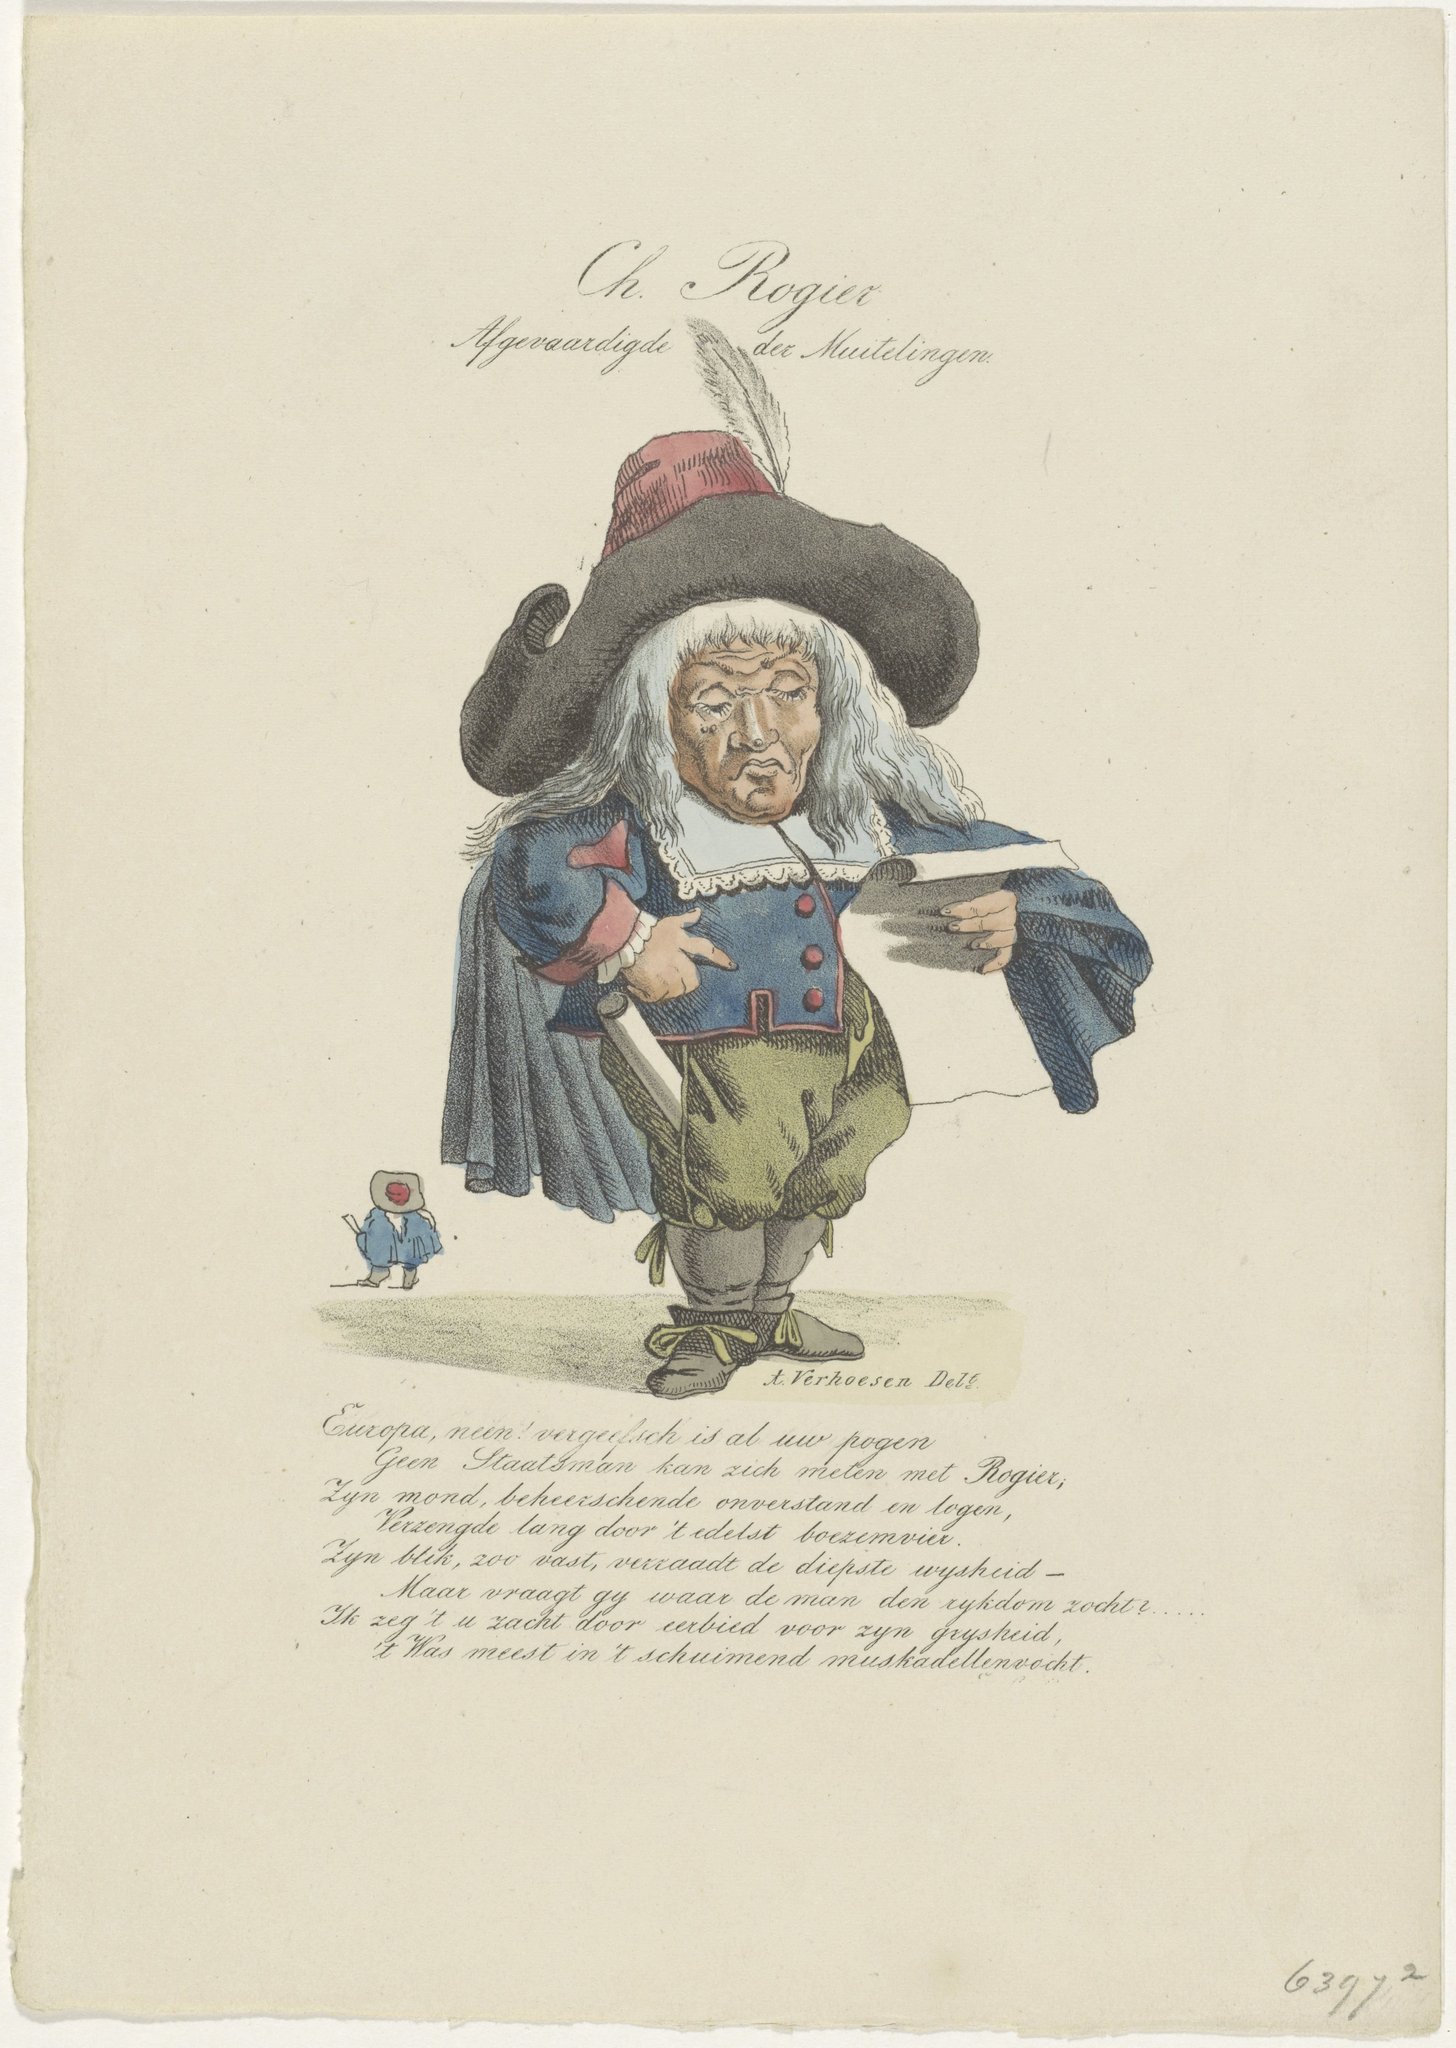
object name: print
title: Spotprent op Charles Rogier, ca. 1830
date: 1830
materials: paper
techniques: hand coloring, lithograph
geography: netherlands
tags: politician, revolutionary government, little people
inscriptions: collector's mark: Lugt 2228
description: Spotprent op de verschillende leden van het Voorlopig Bewind van België in 1830. Charles Rogier als Afgevaardigde der Muitelingen, voorgesteld als een kleine mens met lang haar en een grote hoed met veer, een document lezend. Met achtregelig versje.